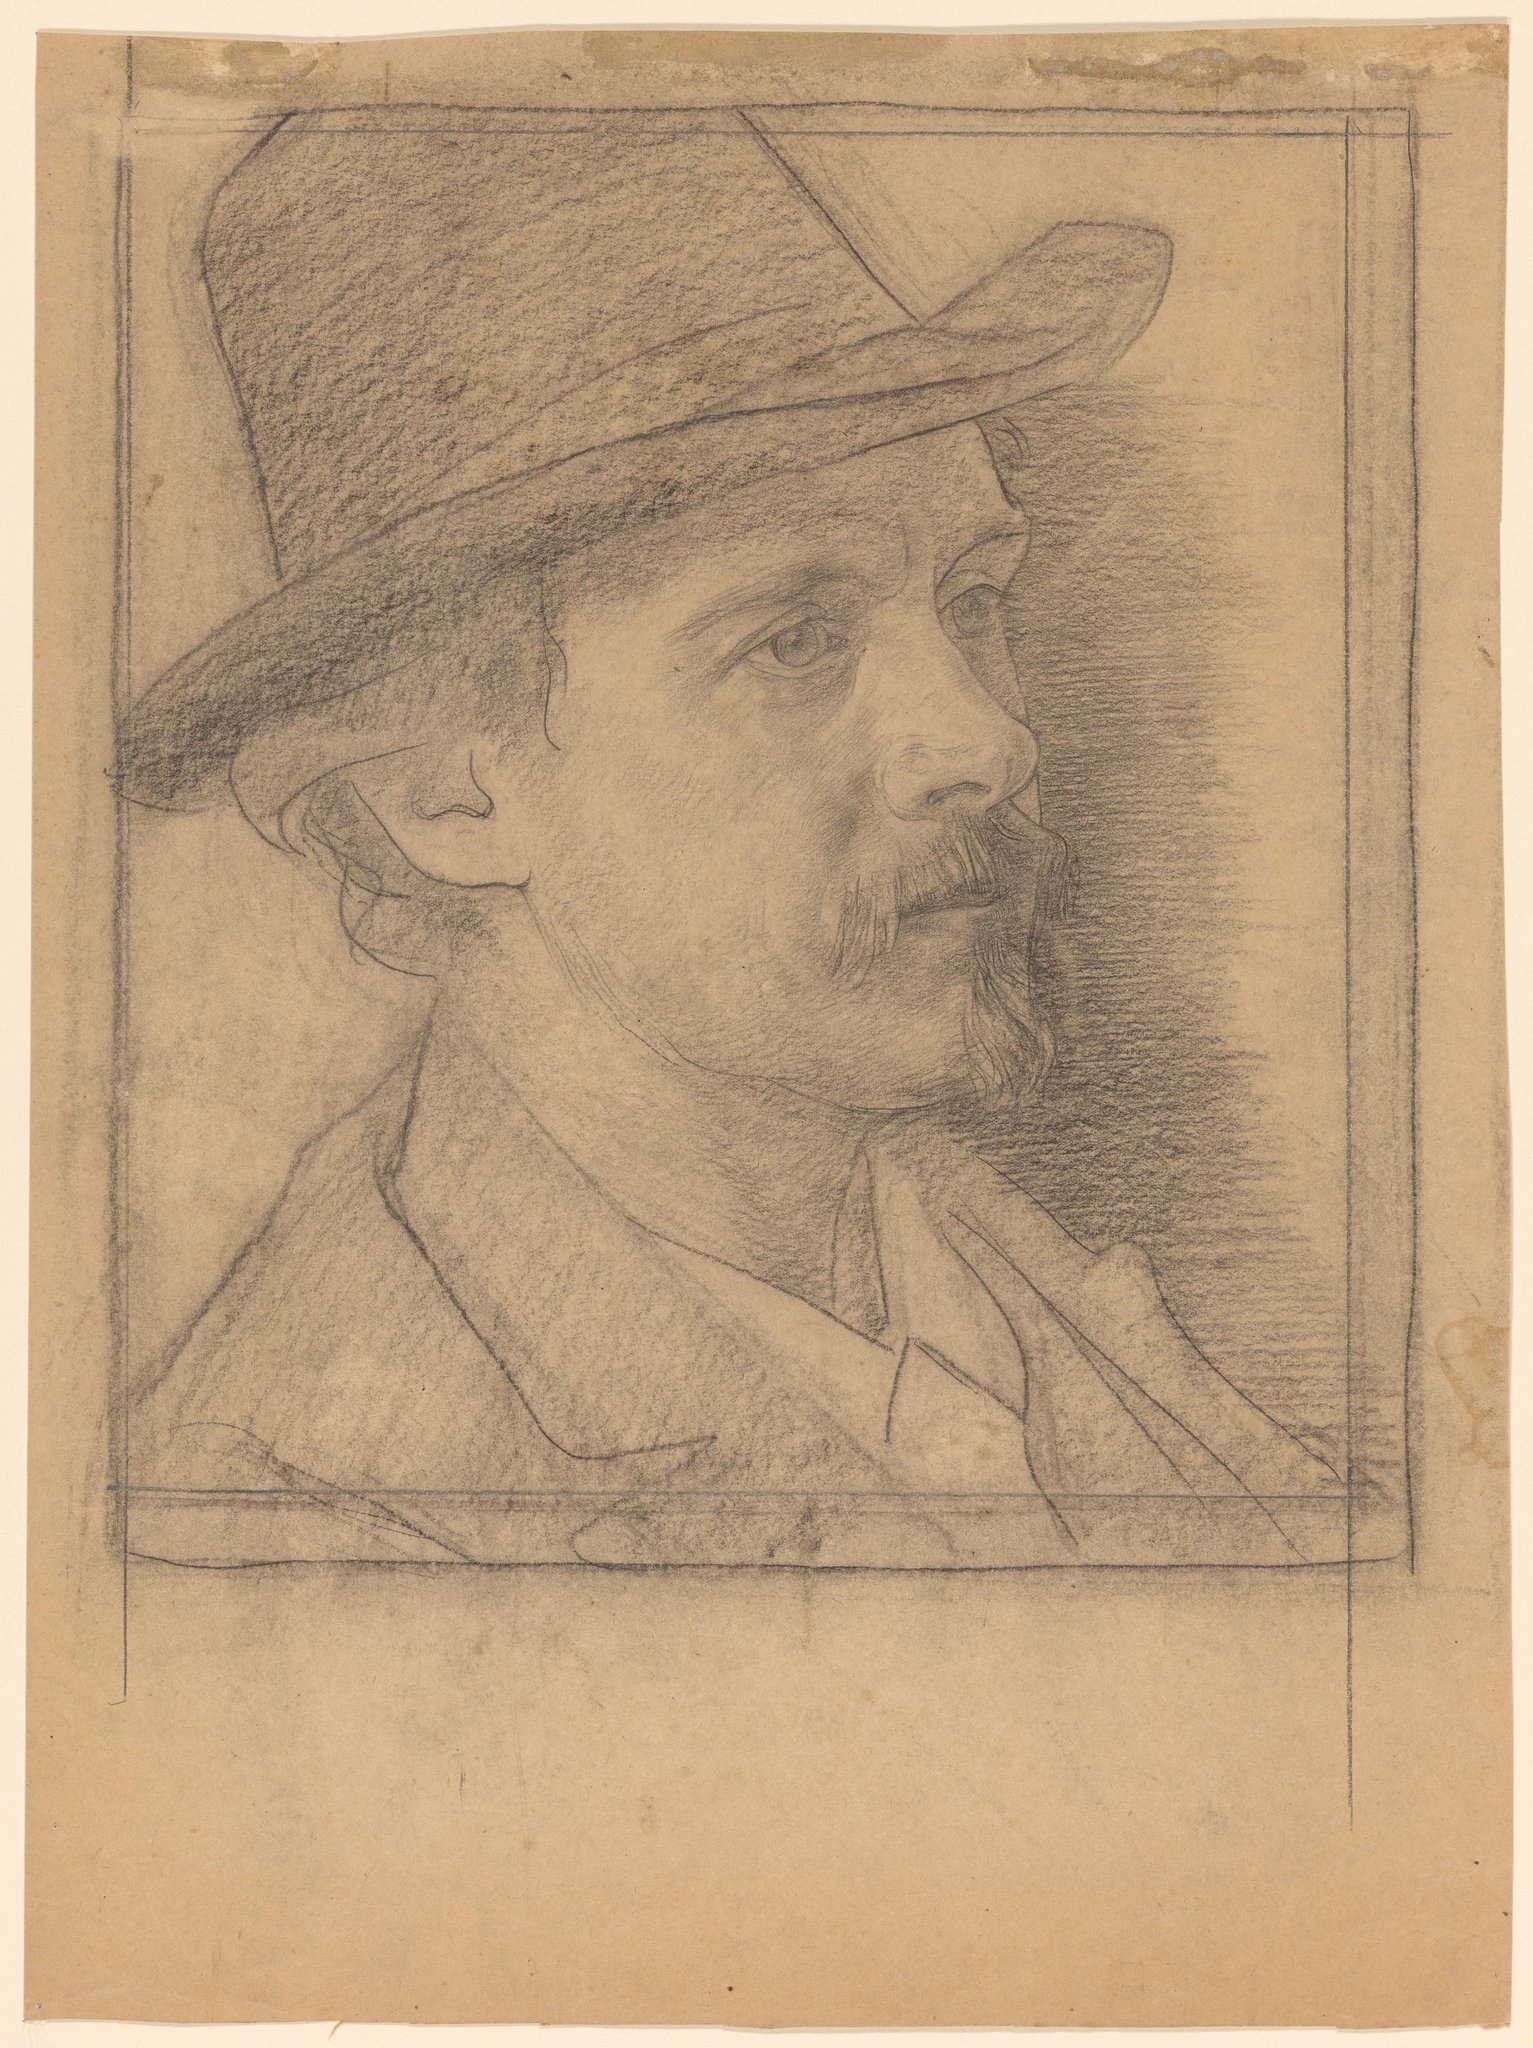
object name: drawing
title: Portret van mr. Willem Robert Veder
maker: jan veth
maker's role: designer, draughtsman, painter, print maker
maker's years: 1864-1925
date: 1874-1925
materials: chalk, paper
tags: historical persons